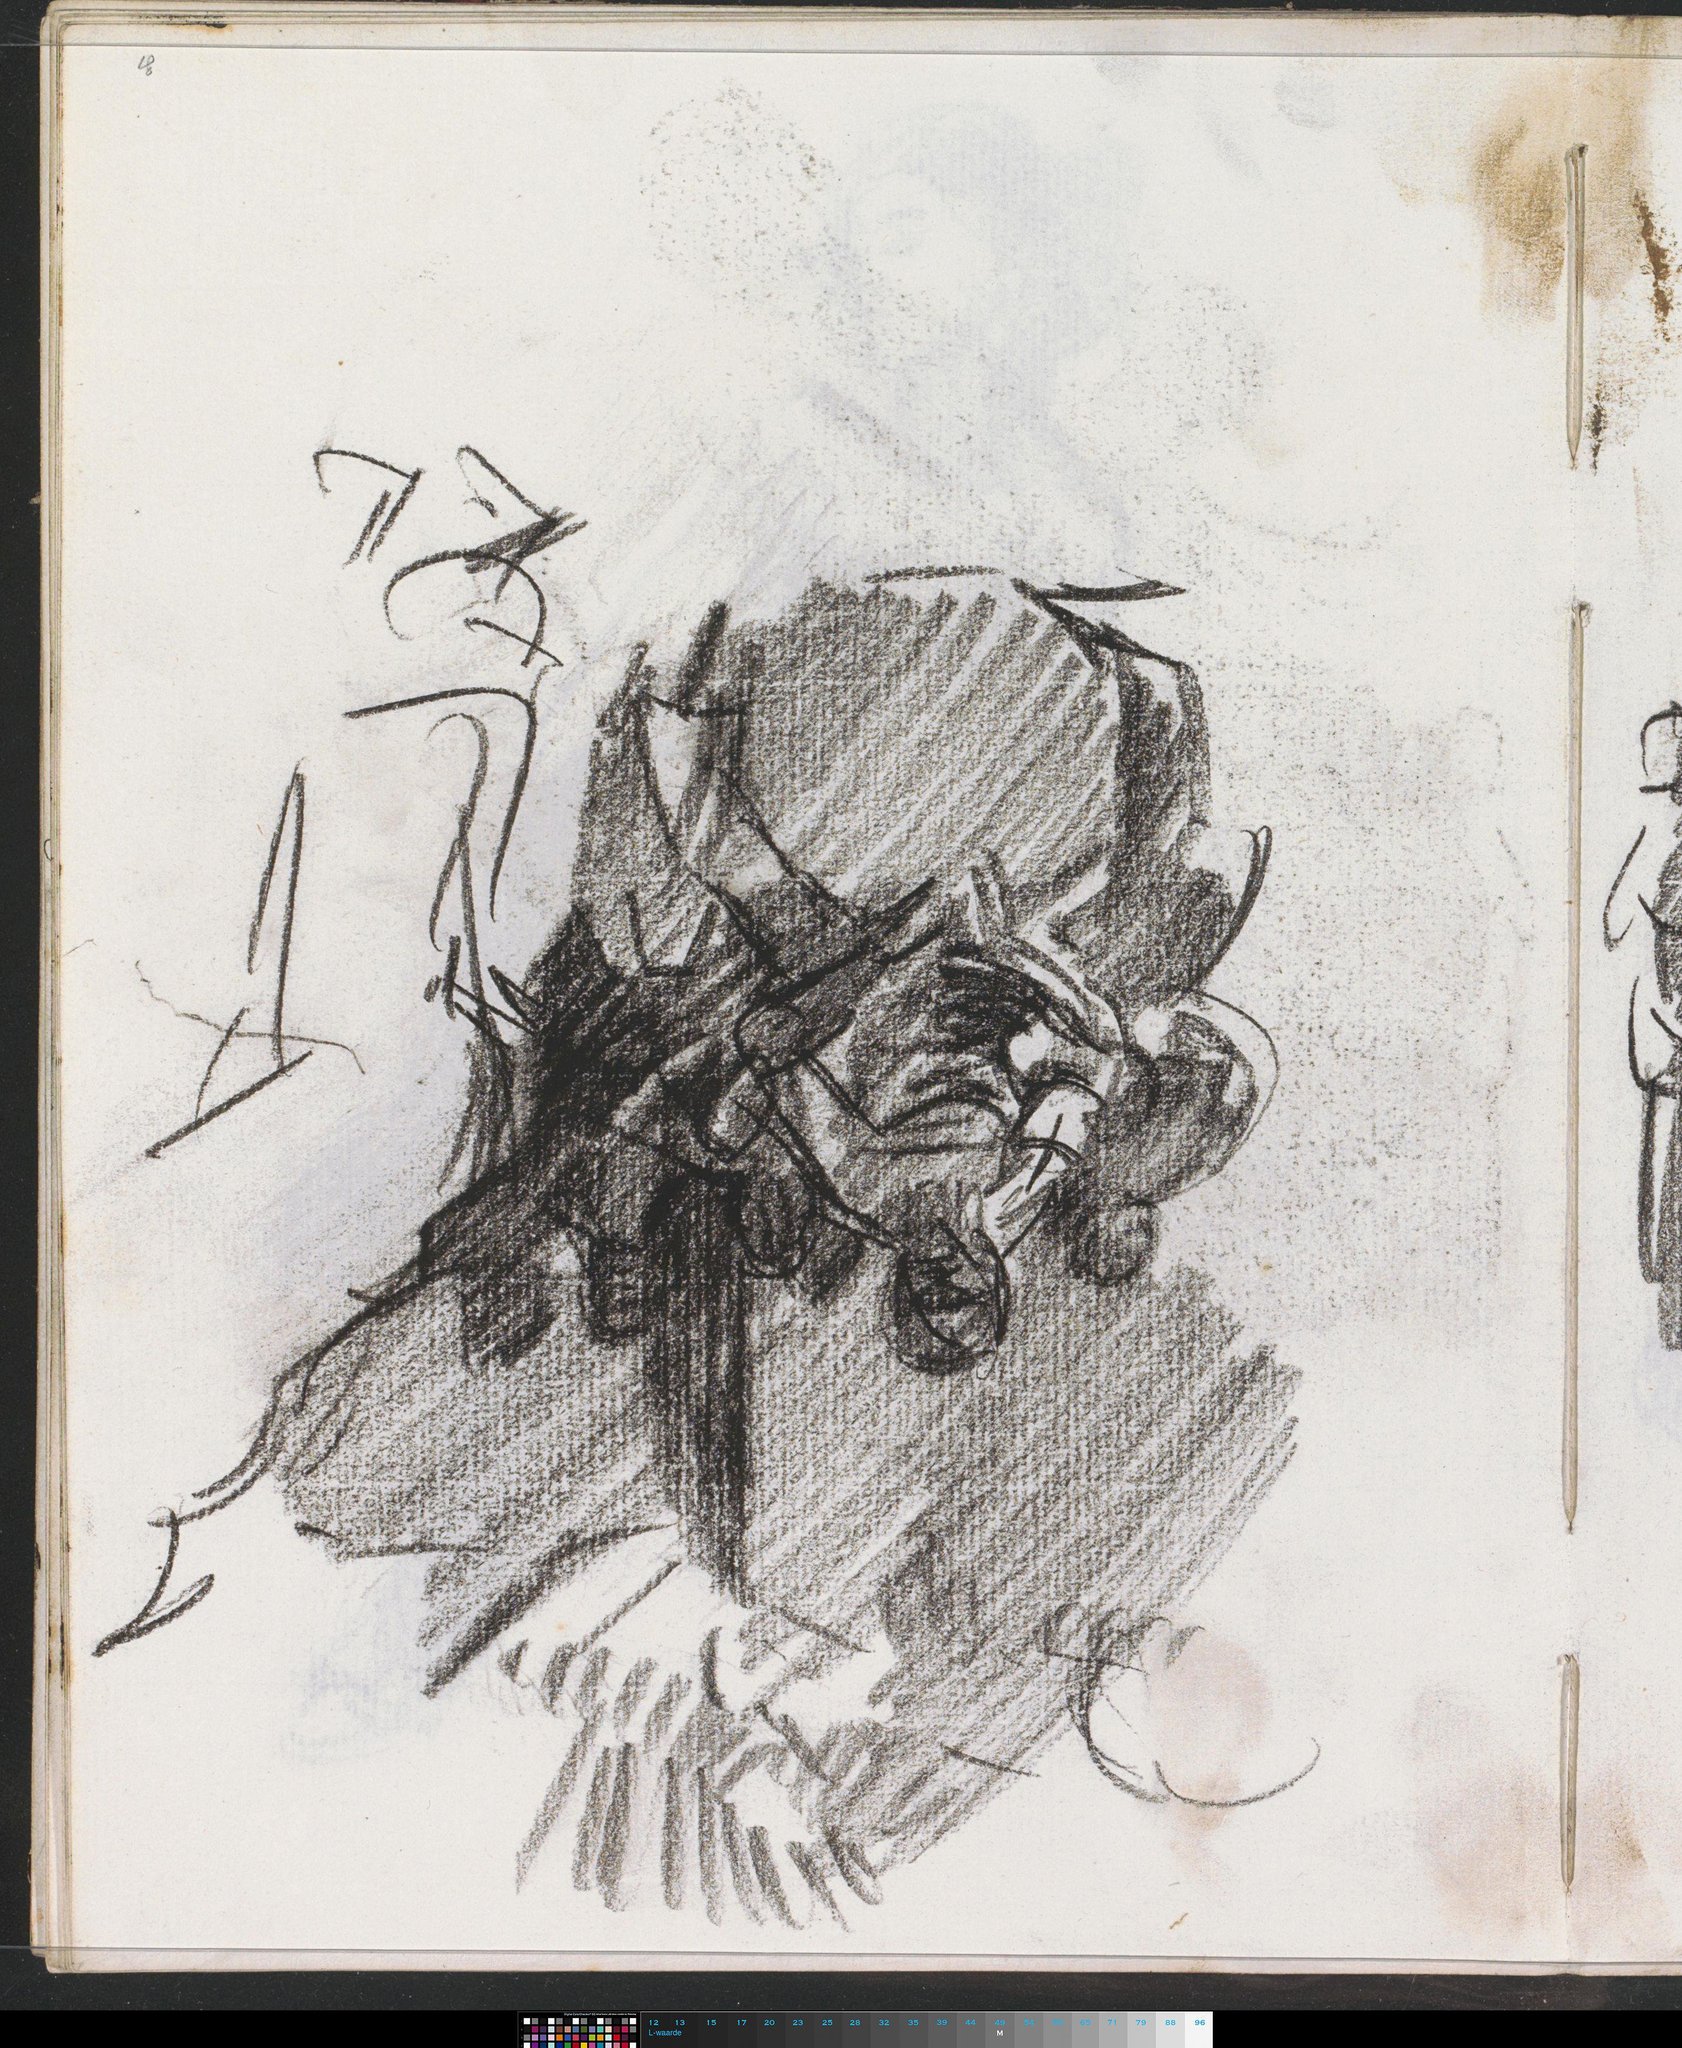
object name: sketchbook leaf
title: Zittende figuren, mogelijk Afrikanen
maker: isaac israels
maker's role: draughtsman, painter, print maker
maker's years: 1865-1934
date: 1875-1934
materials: chalk, paper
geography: the hague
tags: sitting figure - aa - female human figure, dancing, africans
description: Vooraan mogelijk een danseres. Blad 20 verso uit schetsboek XIII met 25 bladen.